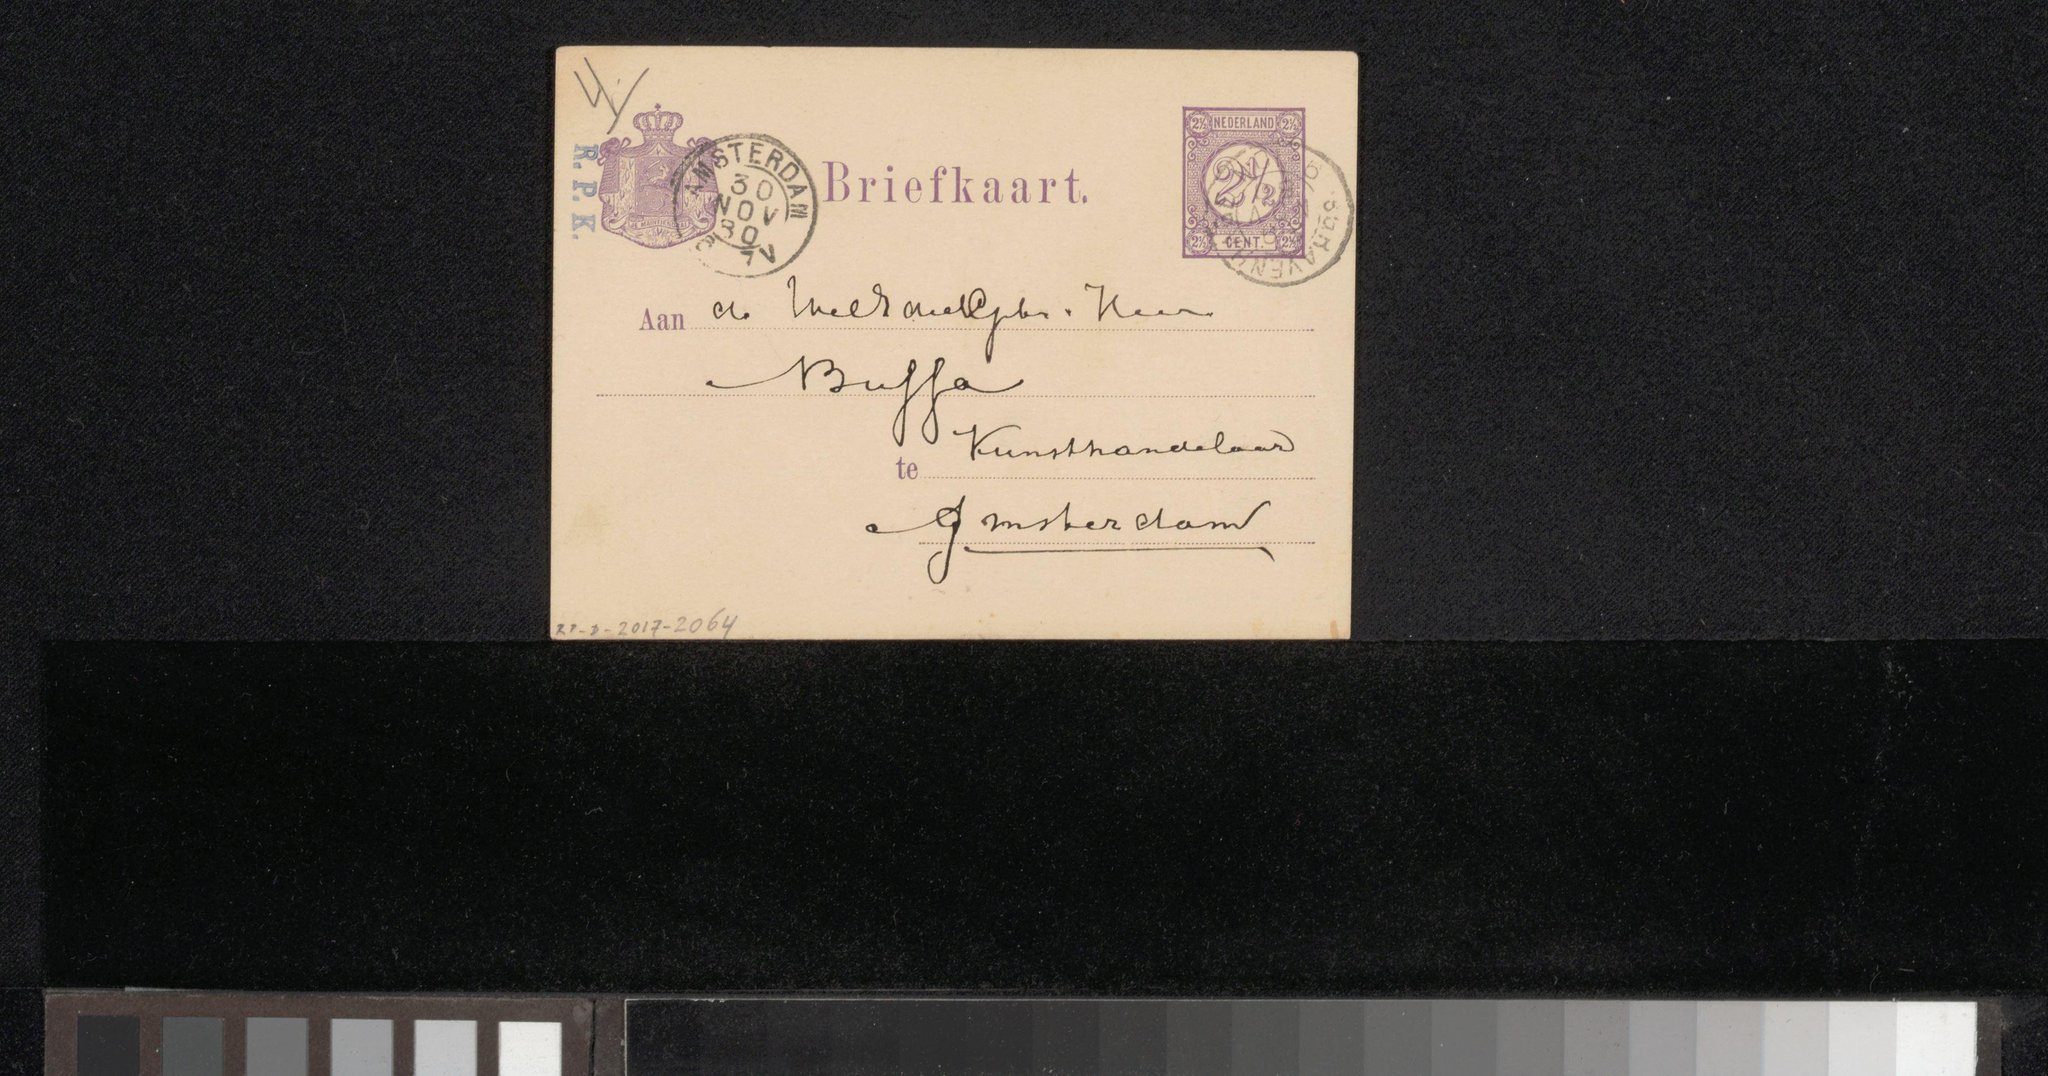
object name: postcard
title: Briefkaart aan Frans Buffa en Zonen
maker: philip windt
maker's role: draughtsman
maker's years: 1847-1921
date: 1880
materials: cardboard, ink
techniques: pen, printing, writing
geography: the hague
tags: publisher, drawing, the hague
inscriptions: collector's mark: Lugt 2233